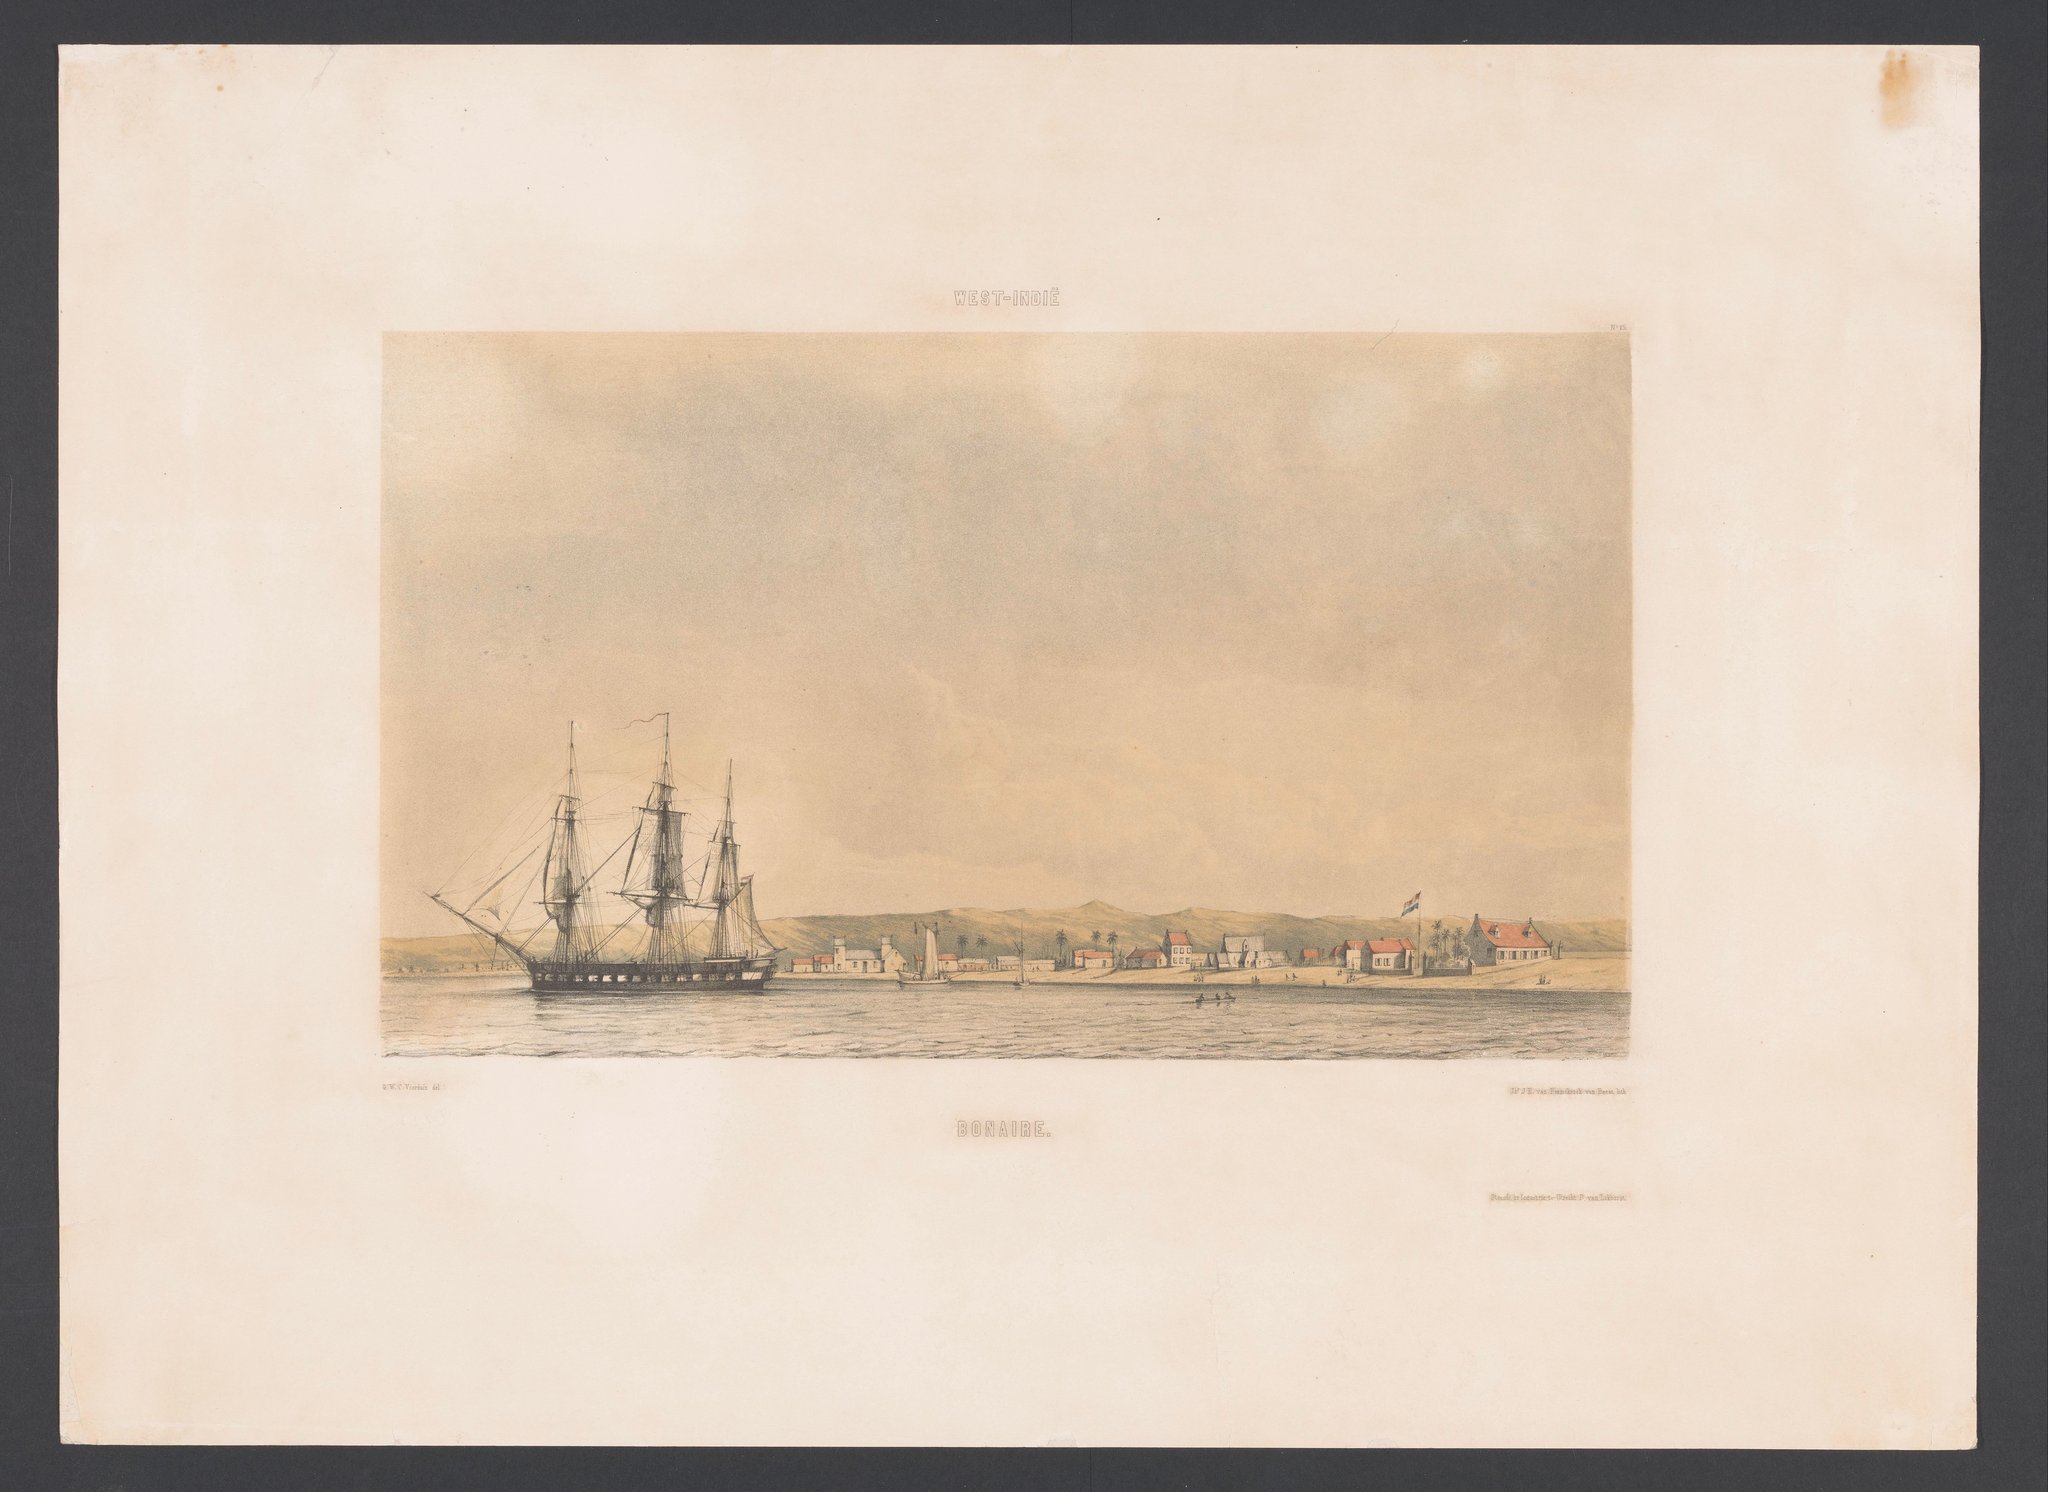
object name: print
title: Bonaire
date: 1860-1862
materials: paper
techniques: lithograph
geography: amsterdam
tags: sailing-ship, sailing-boat, landscapes with waters, waterscapes, seascapes (in the temperate zone)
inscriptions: collector's mark: Lugt 2760, collector's mark: Lugt 2228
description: Volgens het bijbehorende tekstdeel in aparte omslag betreft dit de dertiende prent binnen het plaatwerk 'Gezigten uit Neerland's West-Indien'.